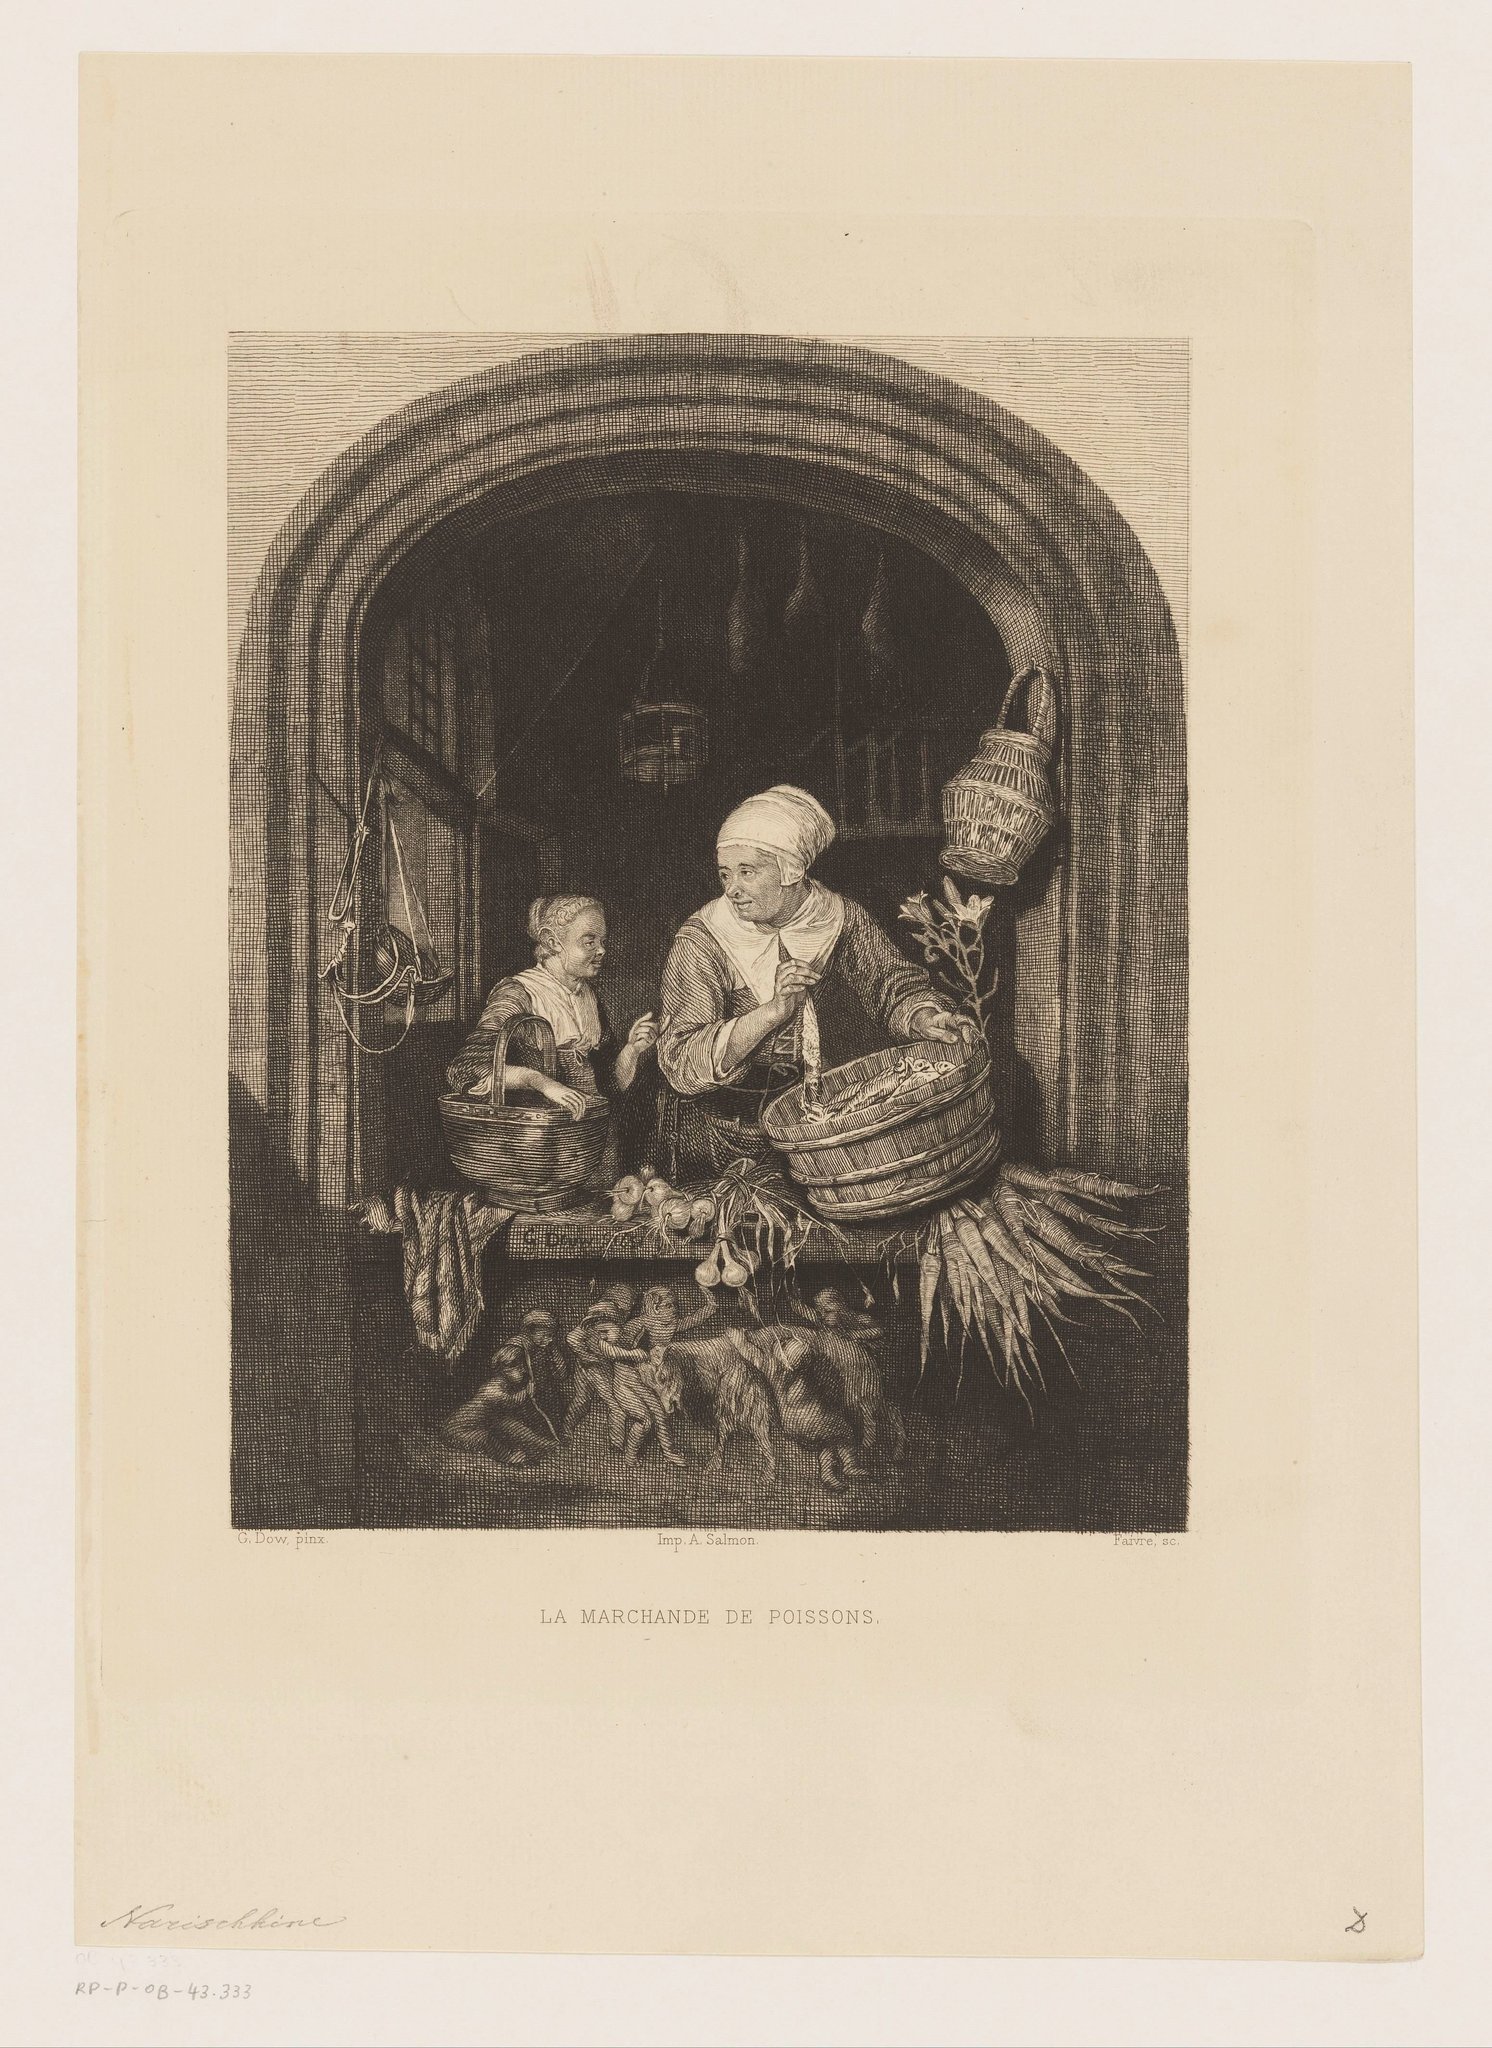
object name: print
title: La marchande de poissons.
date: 1835-1915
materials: paper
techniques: etching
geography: france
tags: fishes, merchant, salesman - bb - women engaged in trade and commerce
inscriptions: collector's mark: Lugt 2228